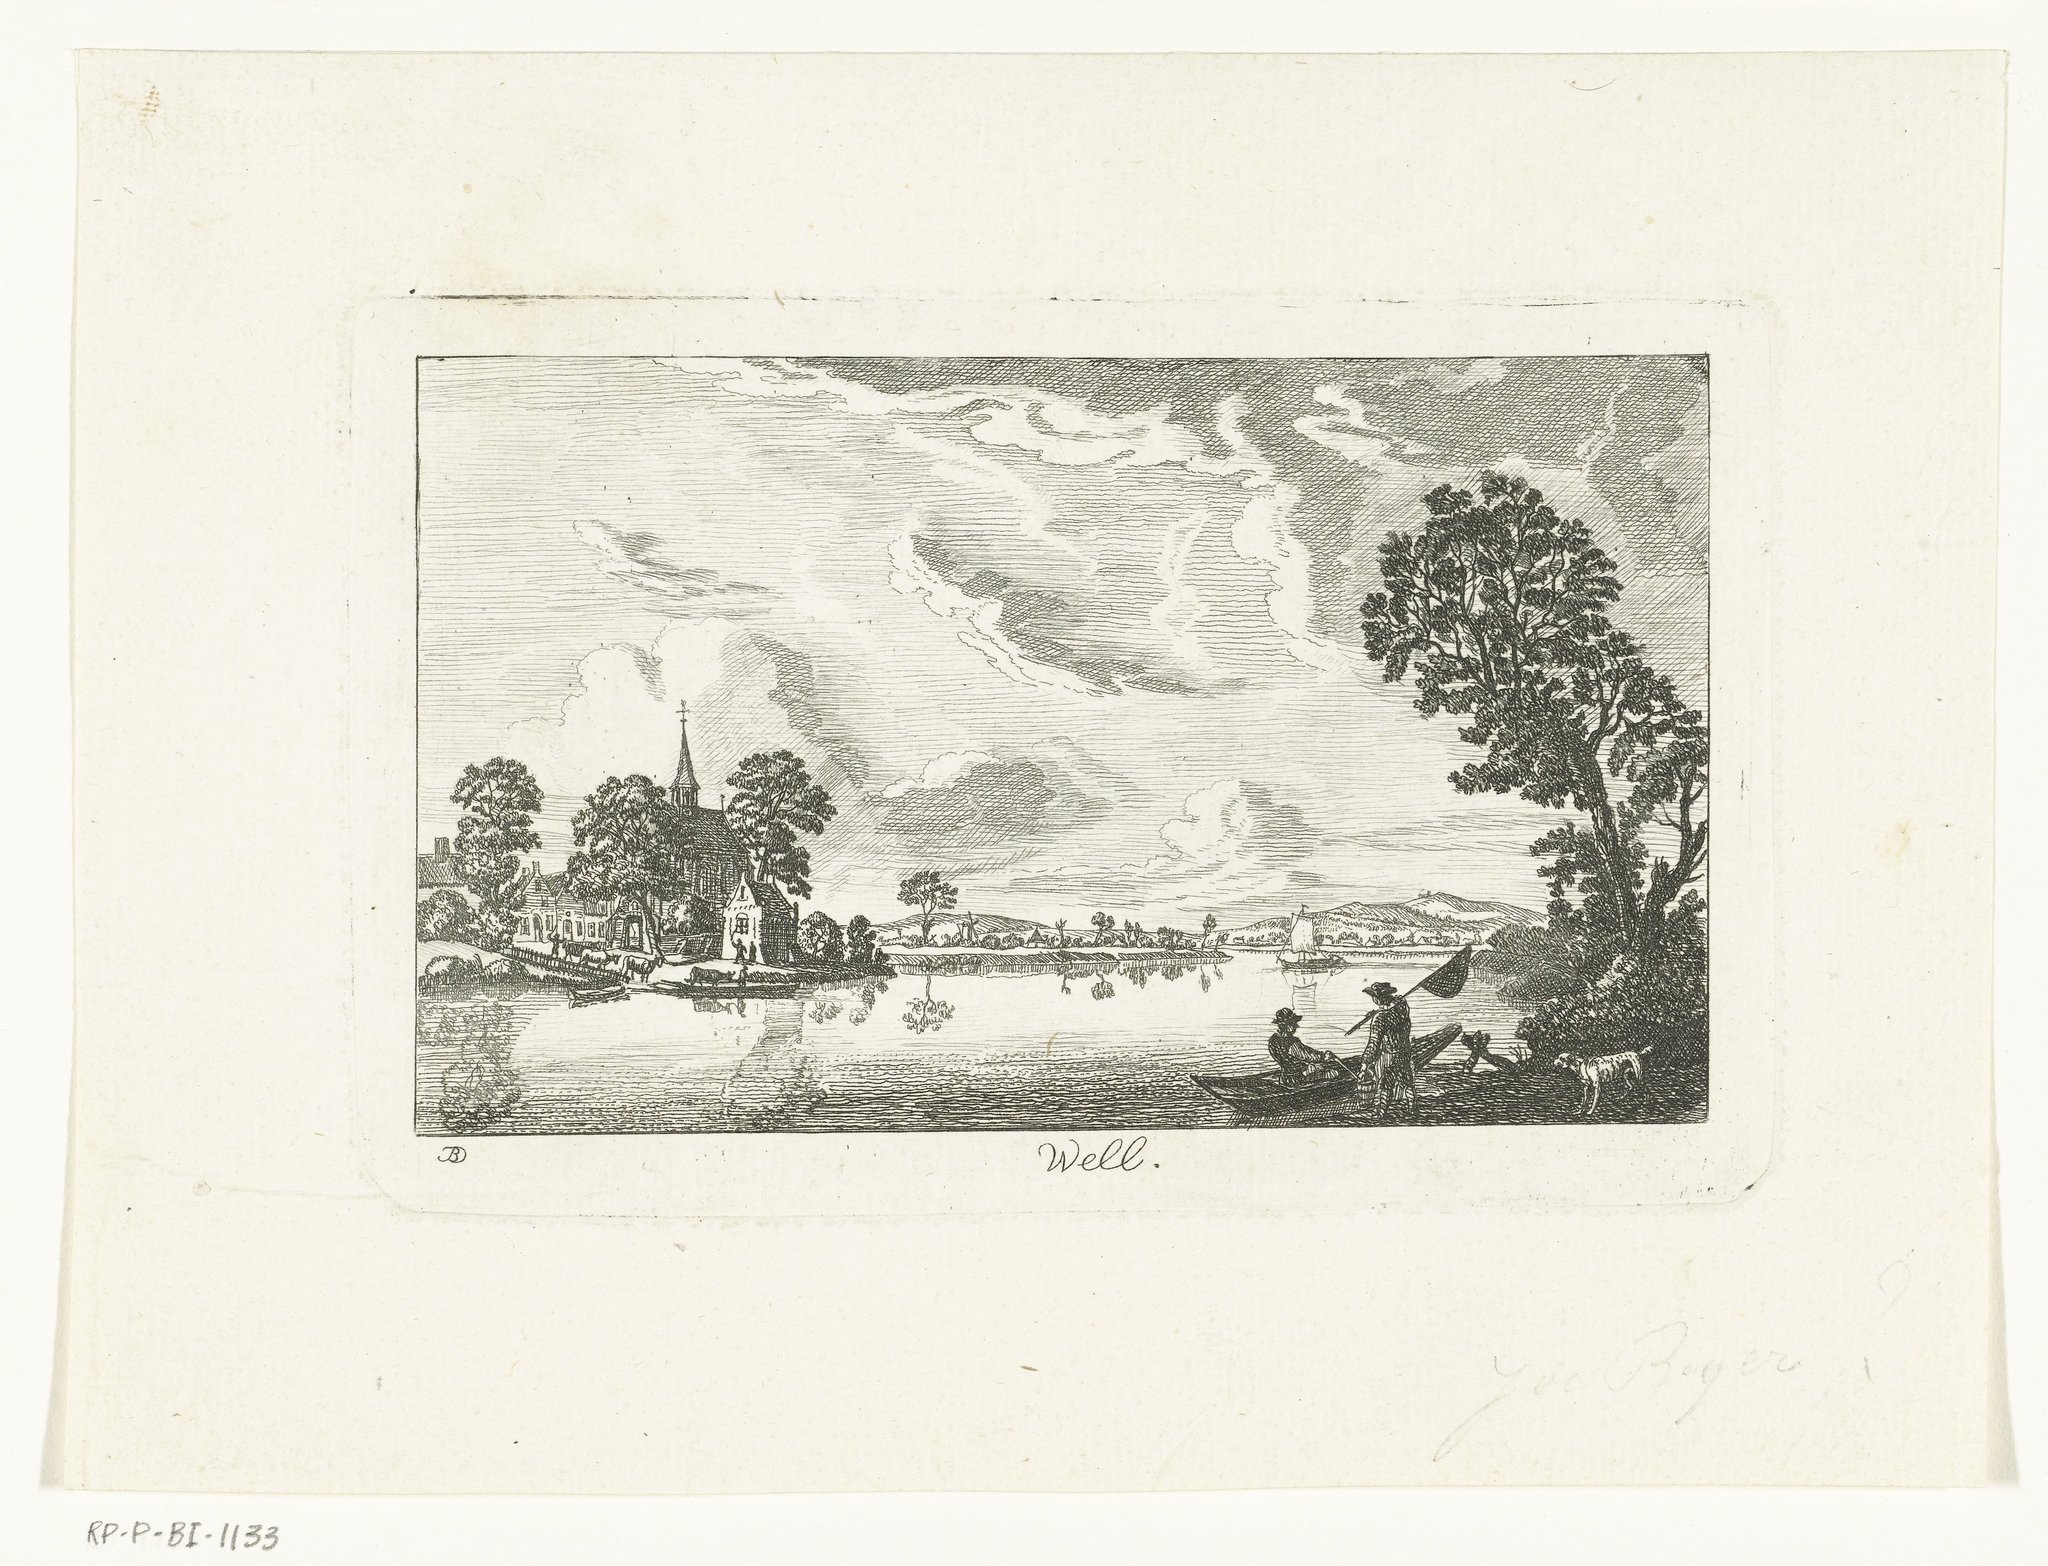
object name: print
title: Well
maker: jan de beijer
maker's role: draughtsman, print maker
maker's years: 1703-1780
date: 1713-1780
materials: paper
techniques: etching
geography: netherlands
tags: river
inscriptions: collector's mark: Lugt 2228